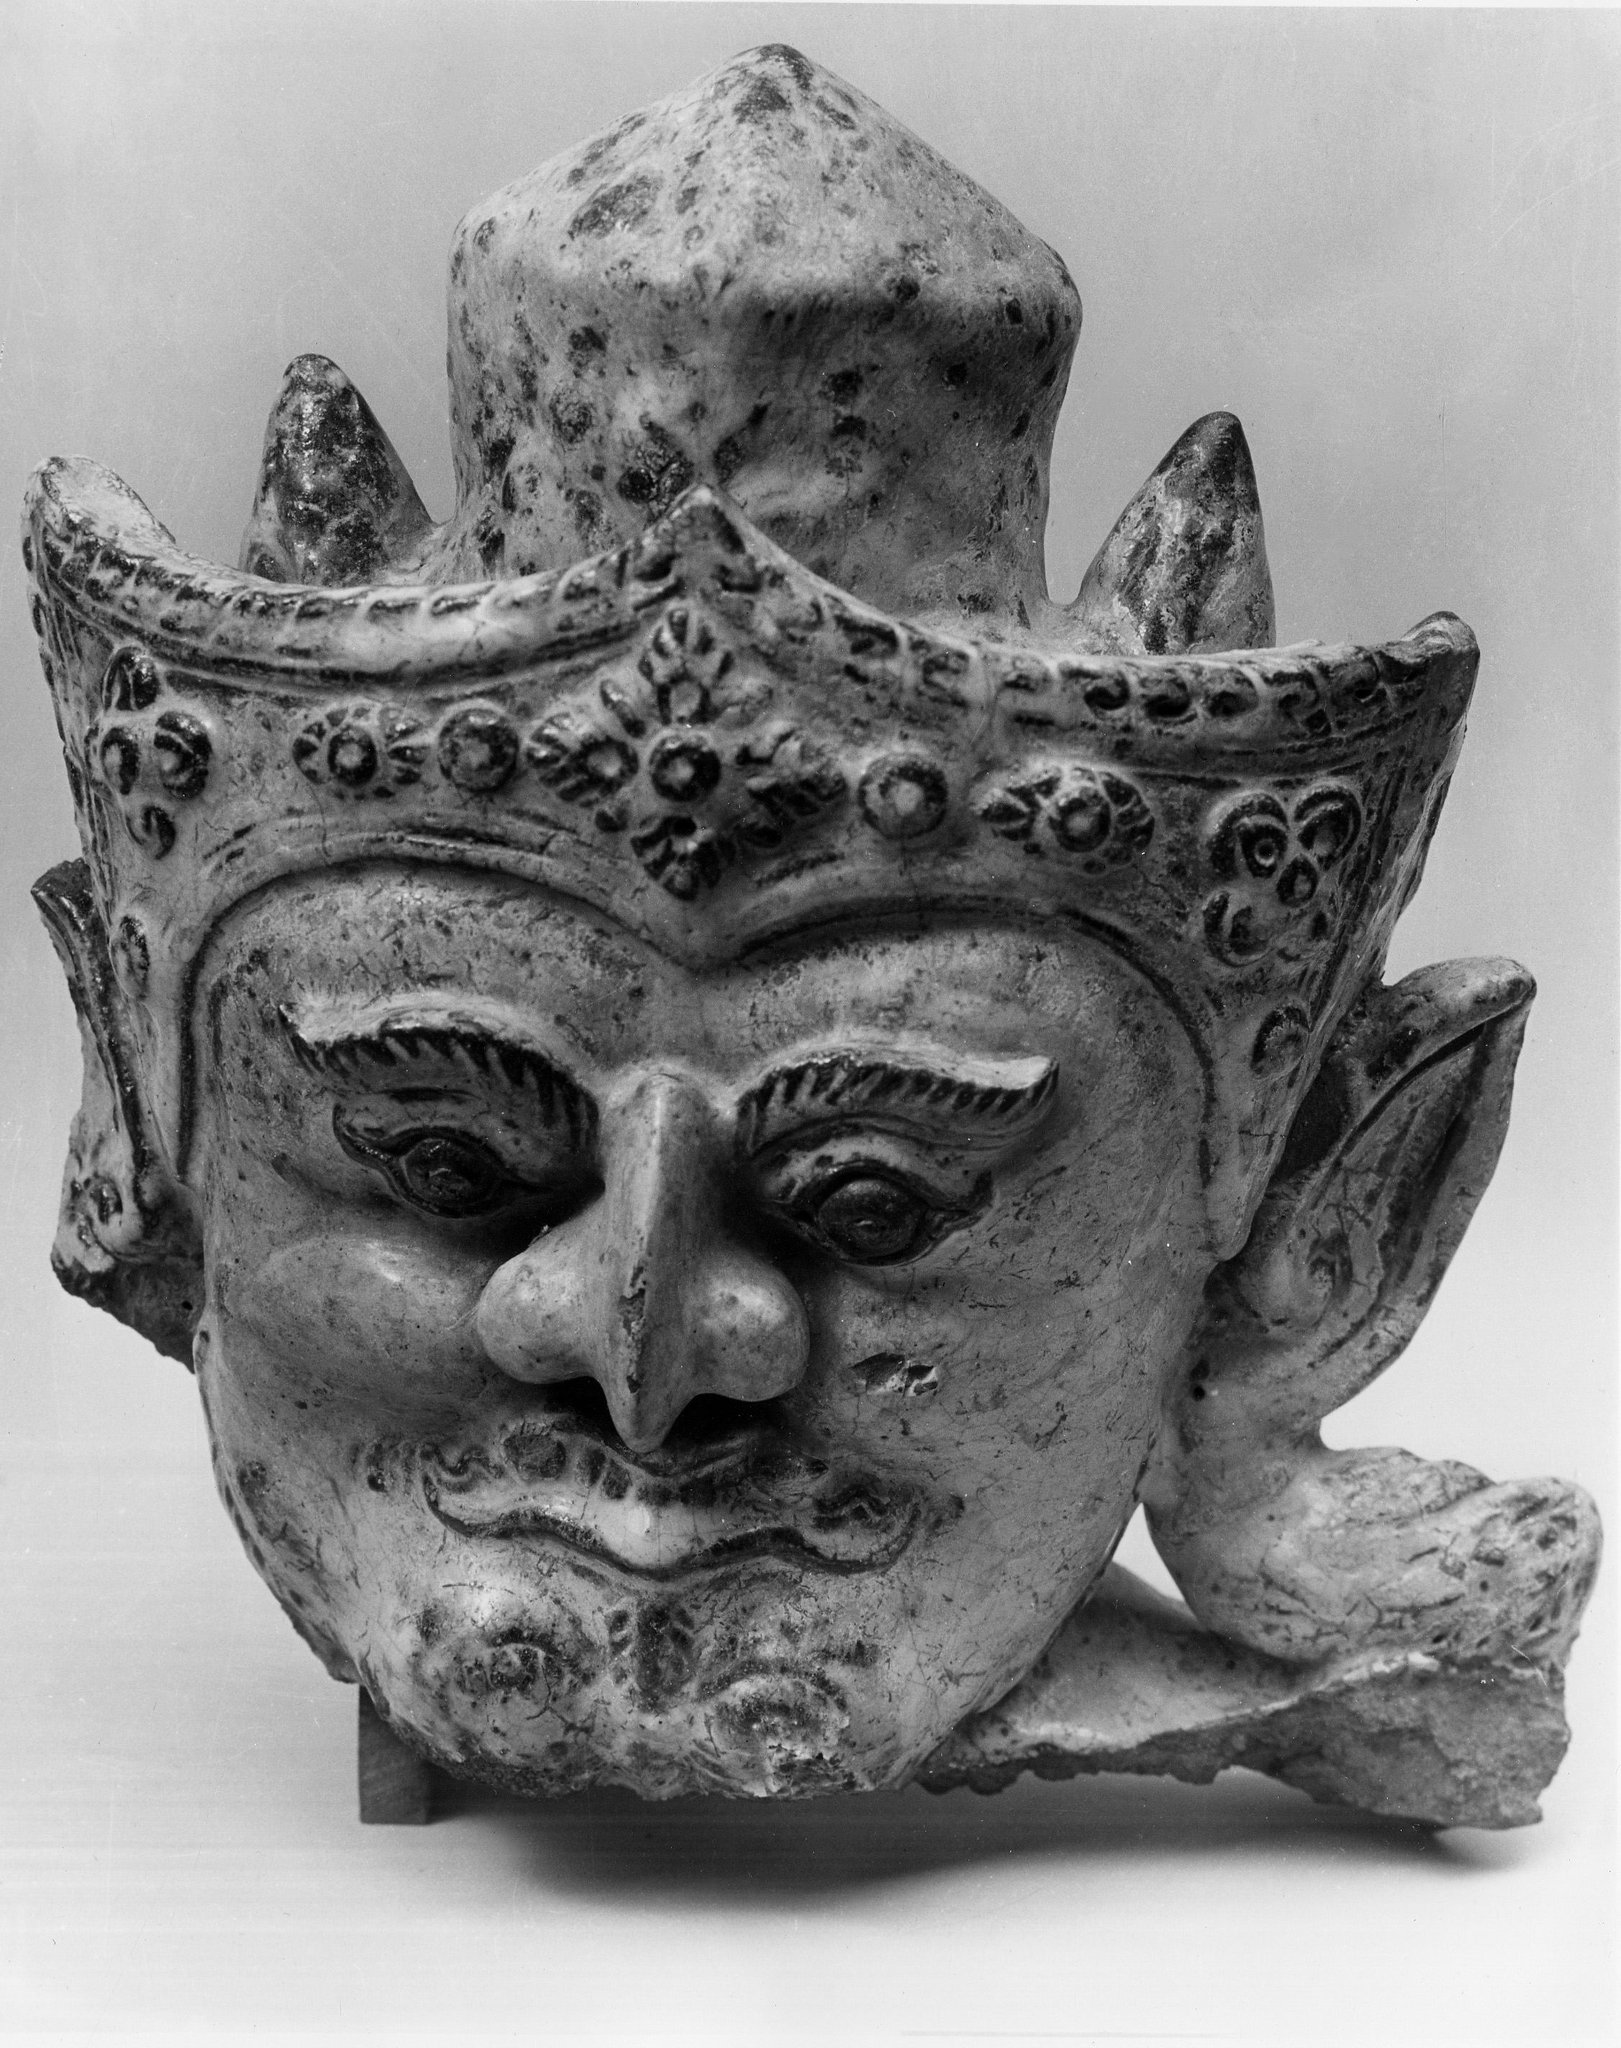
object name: head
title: Head of a Giant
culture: thai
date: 1201-1400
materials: ceramic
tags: heads